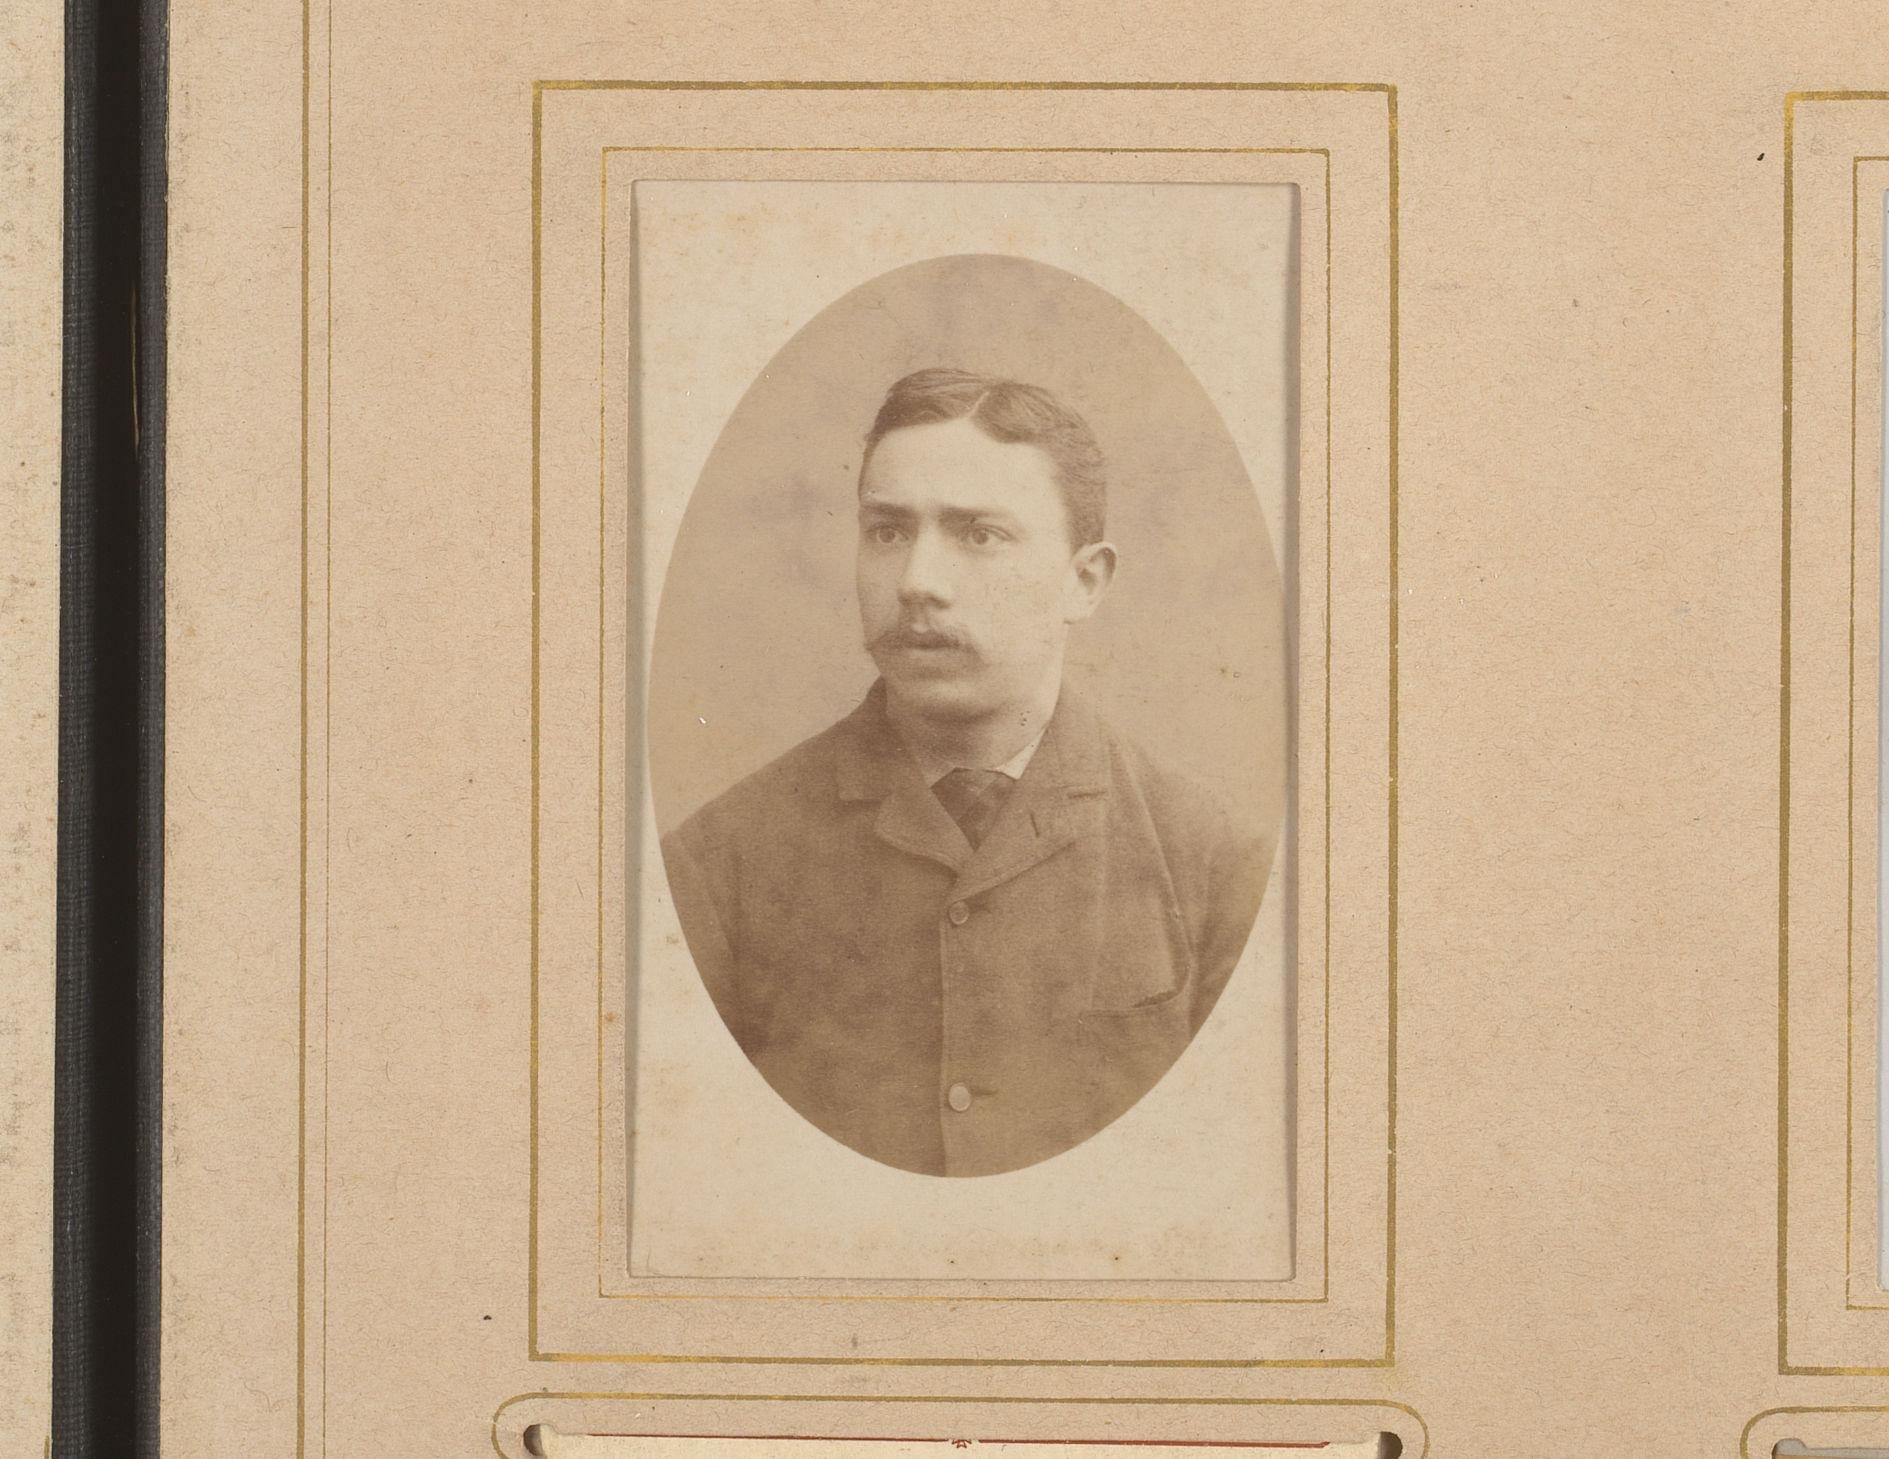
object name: album leaf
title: Portret van een man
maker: j. van crewel jeune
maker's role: fotograaf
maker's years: 1852-1930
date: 1883-1905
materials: cardboard, photographic support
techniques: albumen print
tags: adult man, historical persons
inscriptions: name: ‘J. van Crewel Jne Phot. Anvers’, inscription: ‘Brevet D'invention/ médaille d'argenta/ l'exposition rubens 1881/ (...)’